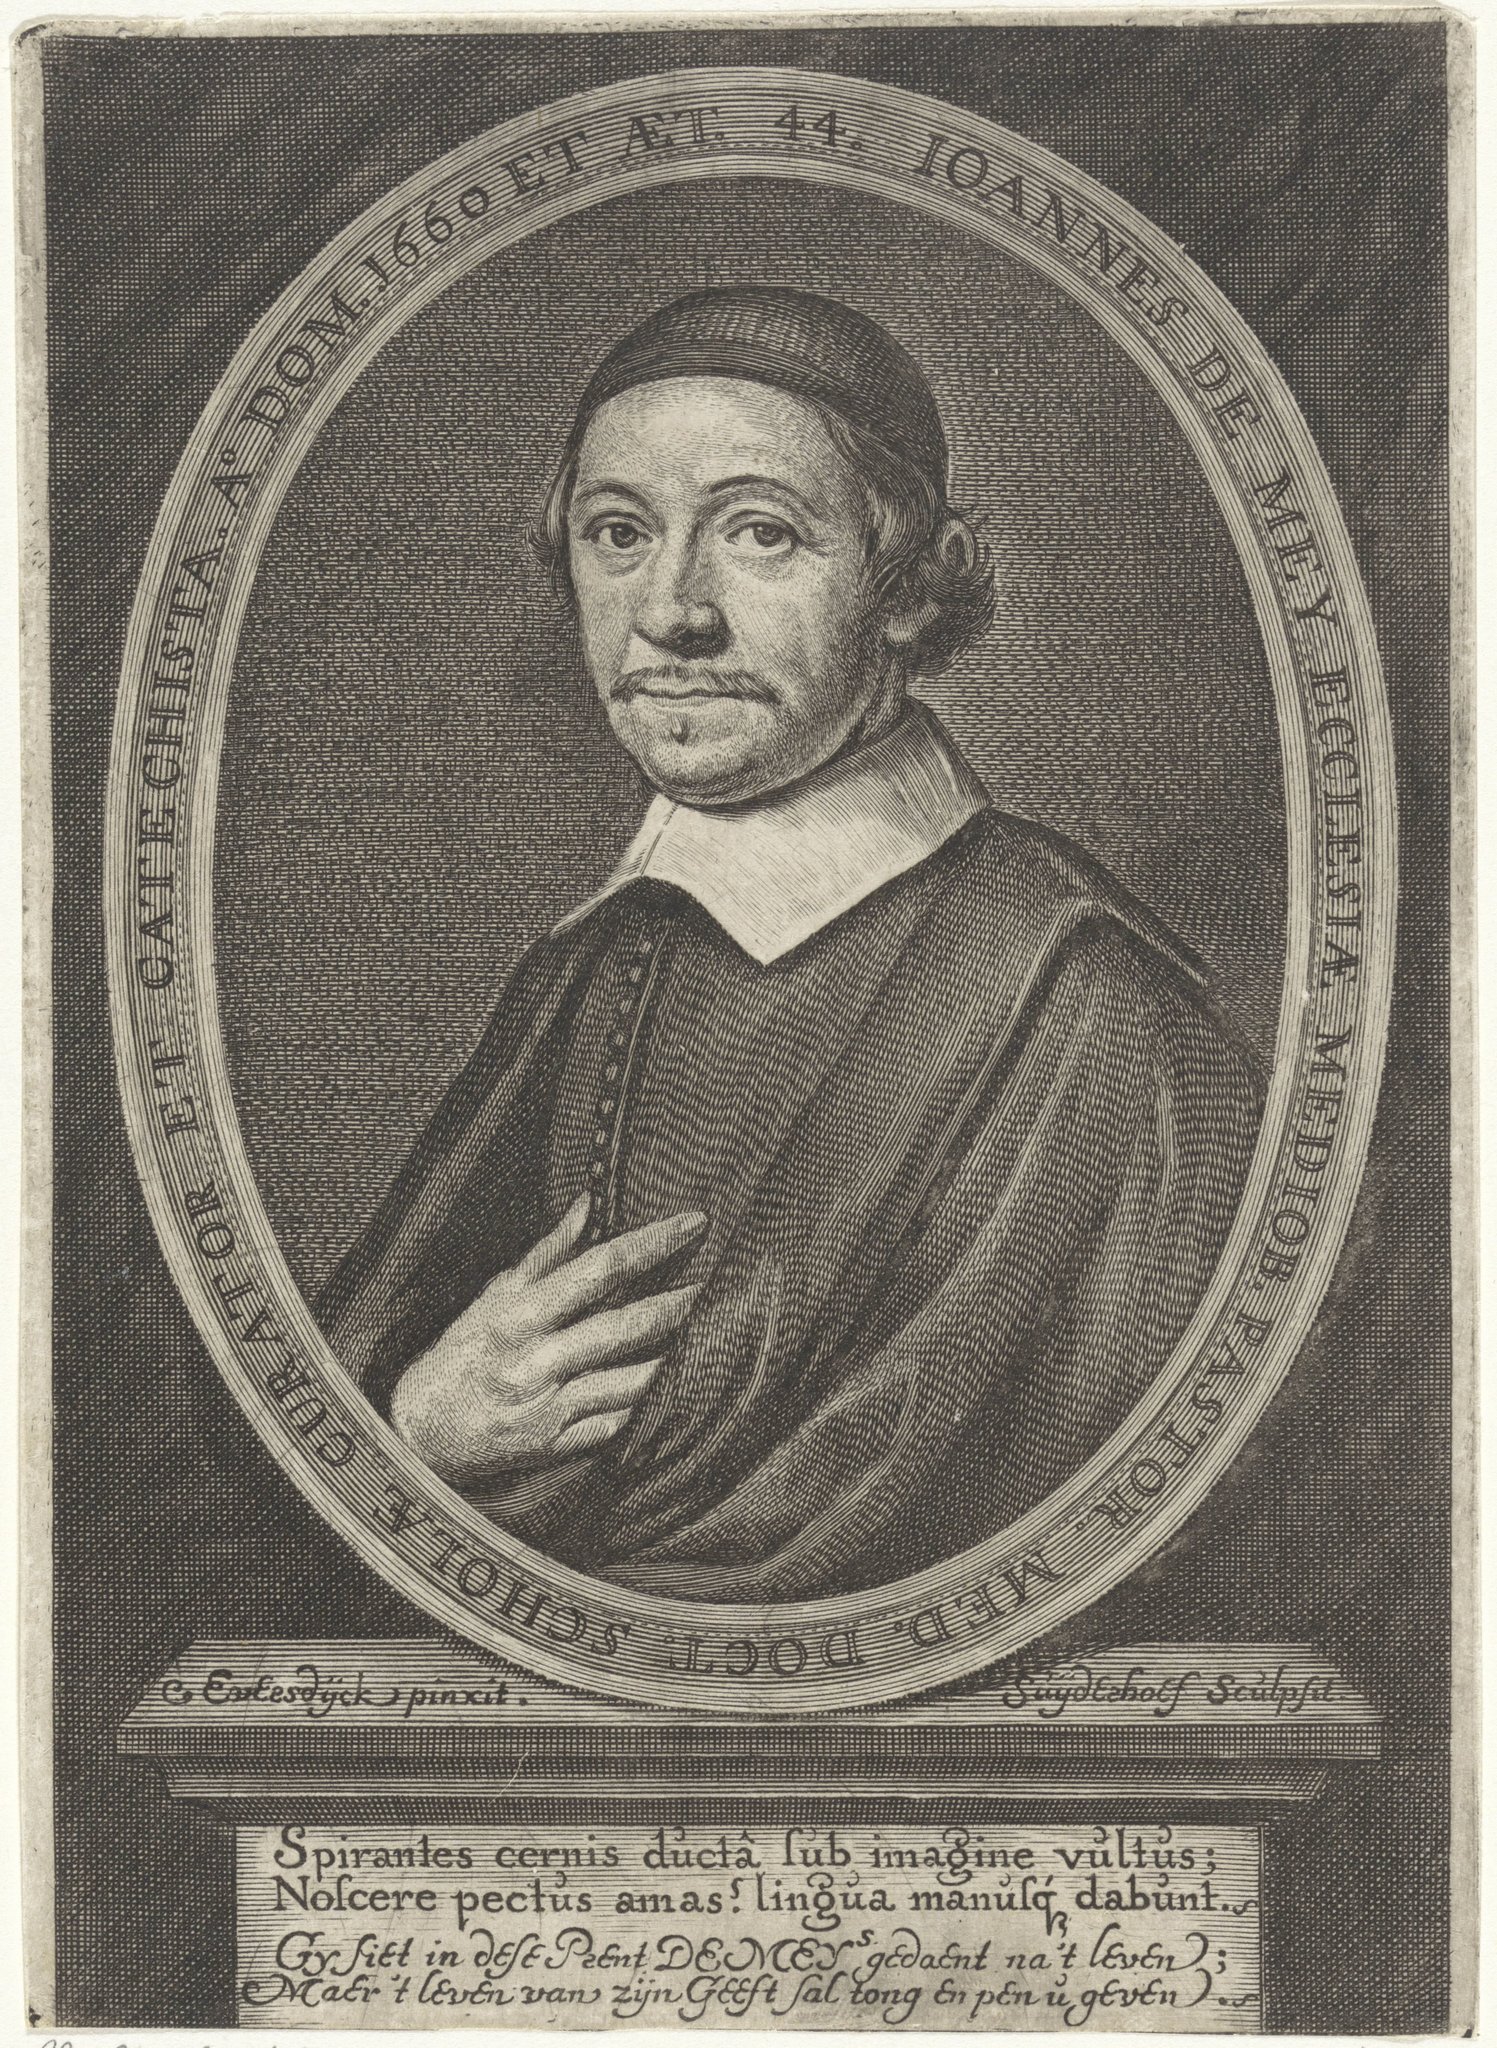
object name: print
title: Portret van Johannes de Mey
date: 1660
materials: paper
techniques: engraving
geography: haarlem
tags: theoloog, johannes de mey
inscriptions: collector's mark: Lugt 240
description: Portret van Joannes de Mey, predikant en catecheet van de Latijnse school te Middelburg, op 44-jarige leeftijd. Onderaan in de marge een tweeregelig vers in het Latijn en in het Nederlands.